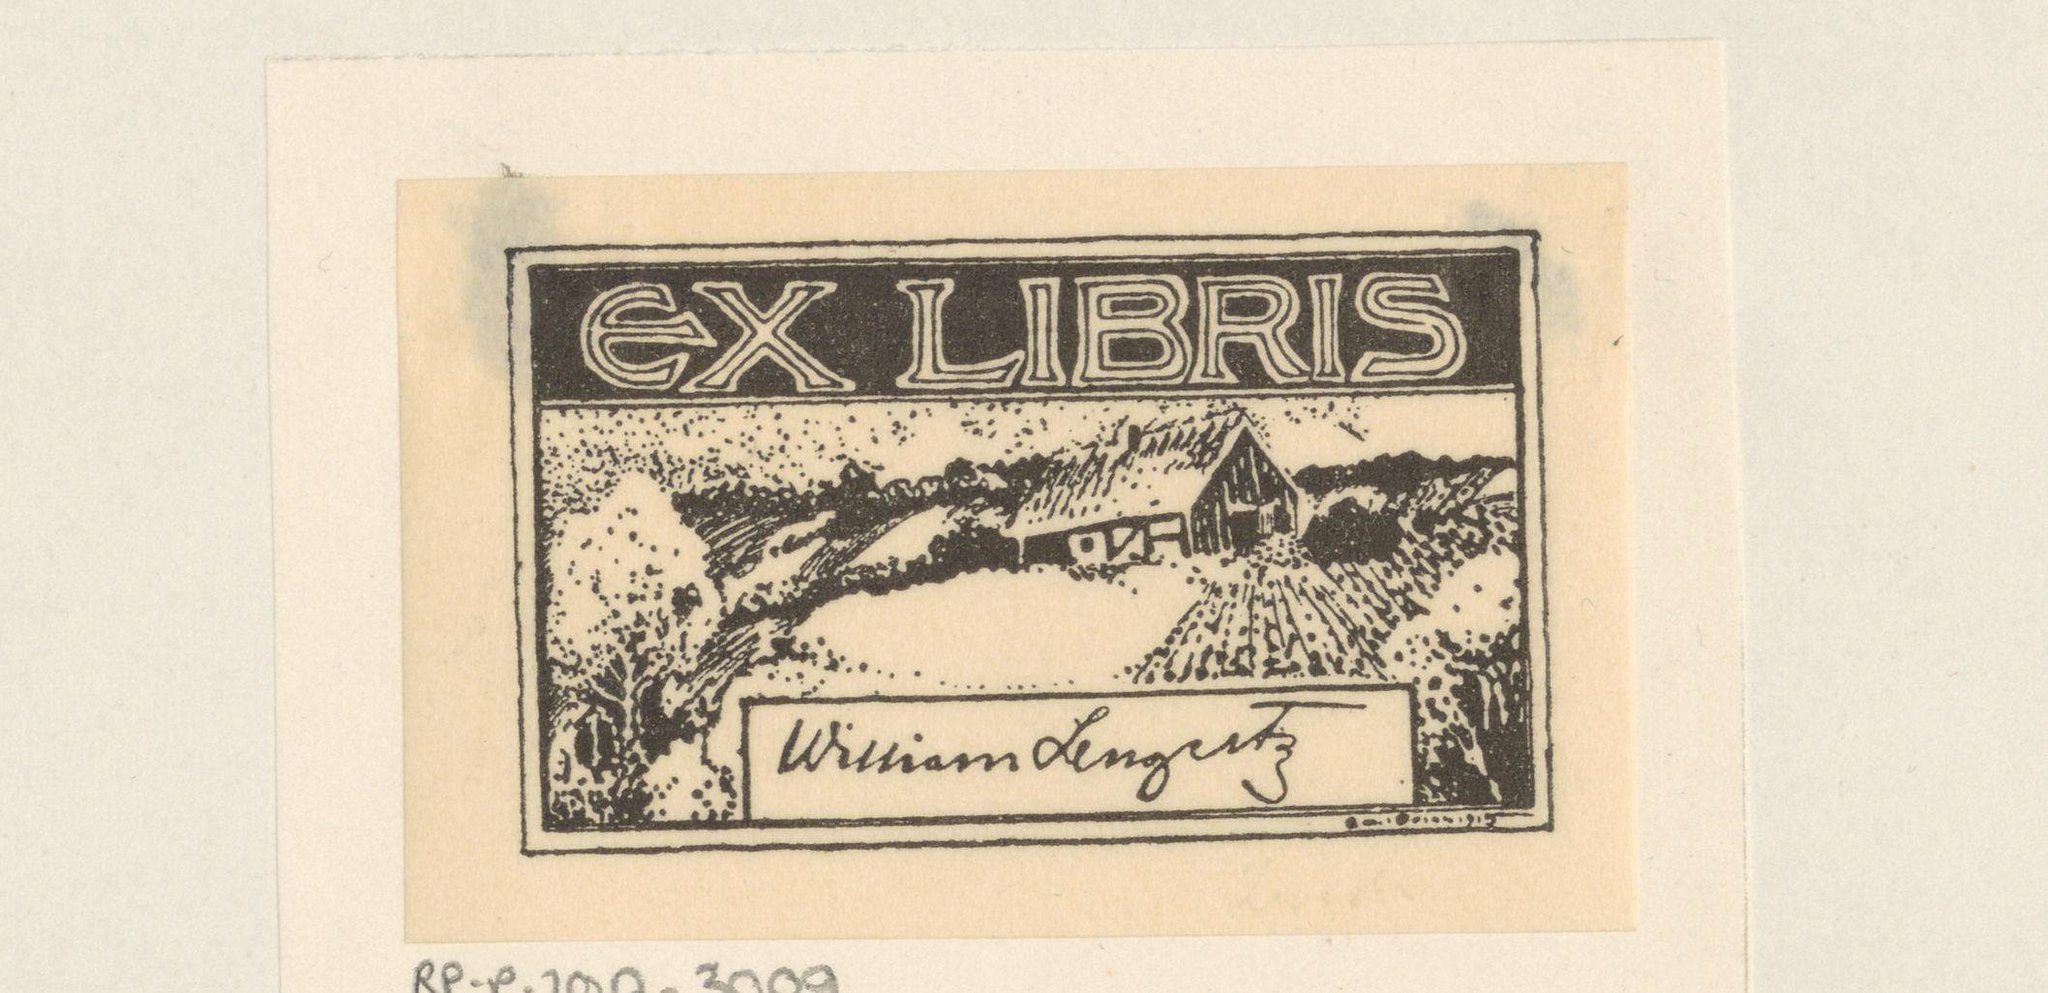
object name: bookplate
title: Ex libris van Wiliam Lengertz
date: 1915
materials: paper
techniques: printing block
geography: sweden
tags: meadow, pasture, cottage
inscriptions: date